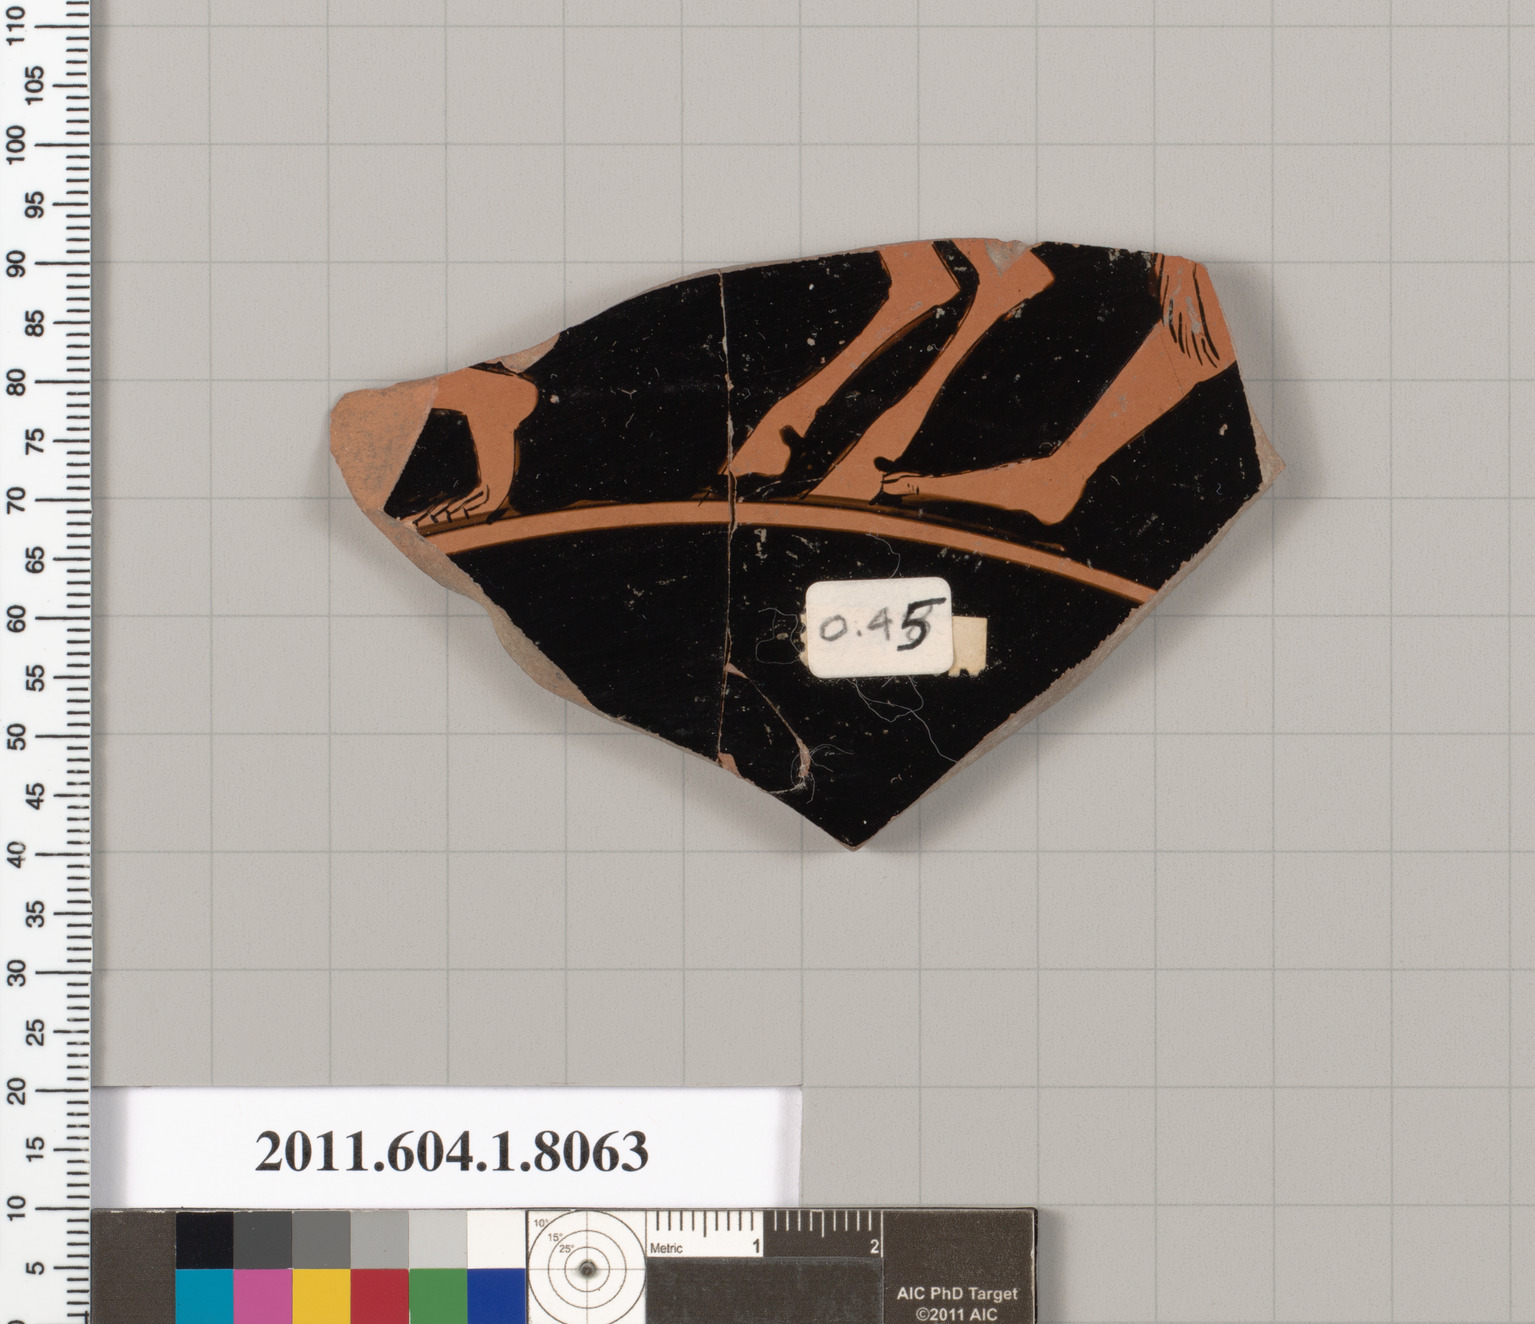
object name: kylix fragment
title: Terracotta fragment of a kylix (drinking cup)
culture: greek, attic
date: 510-500 BCE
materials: terracotta